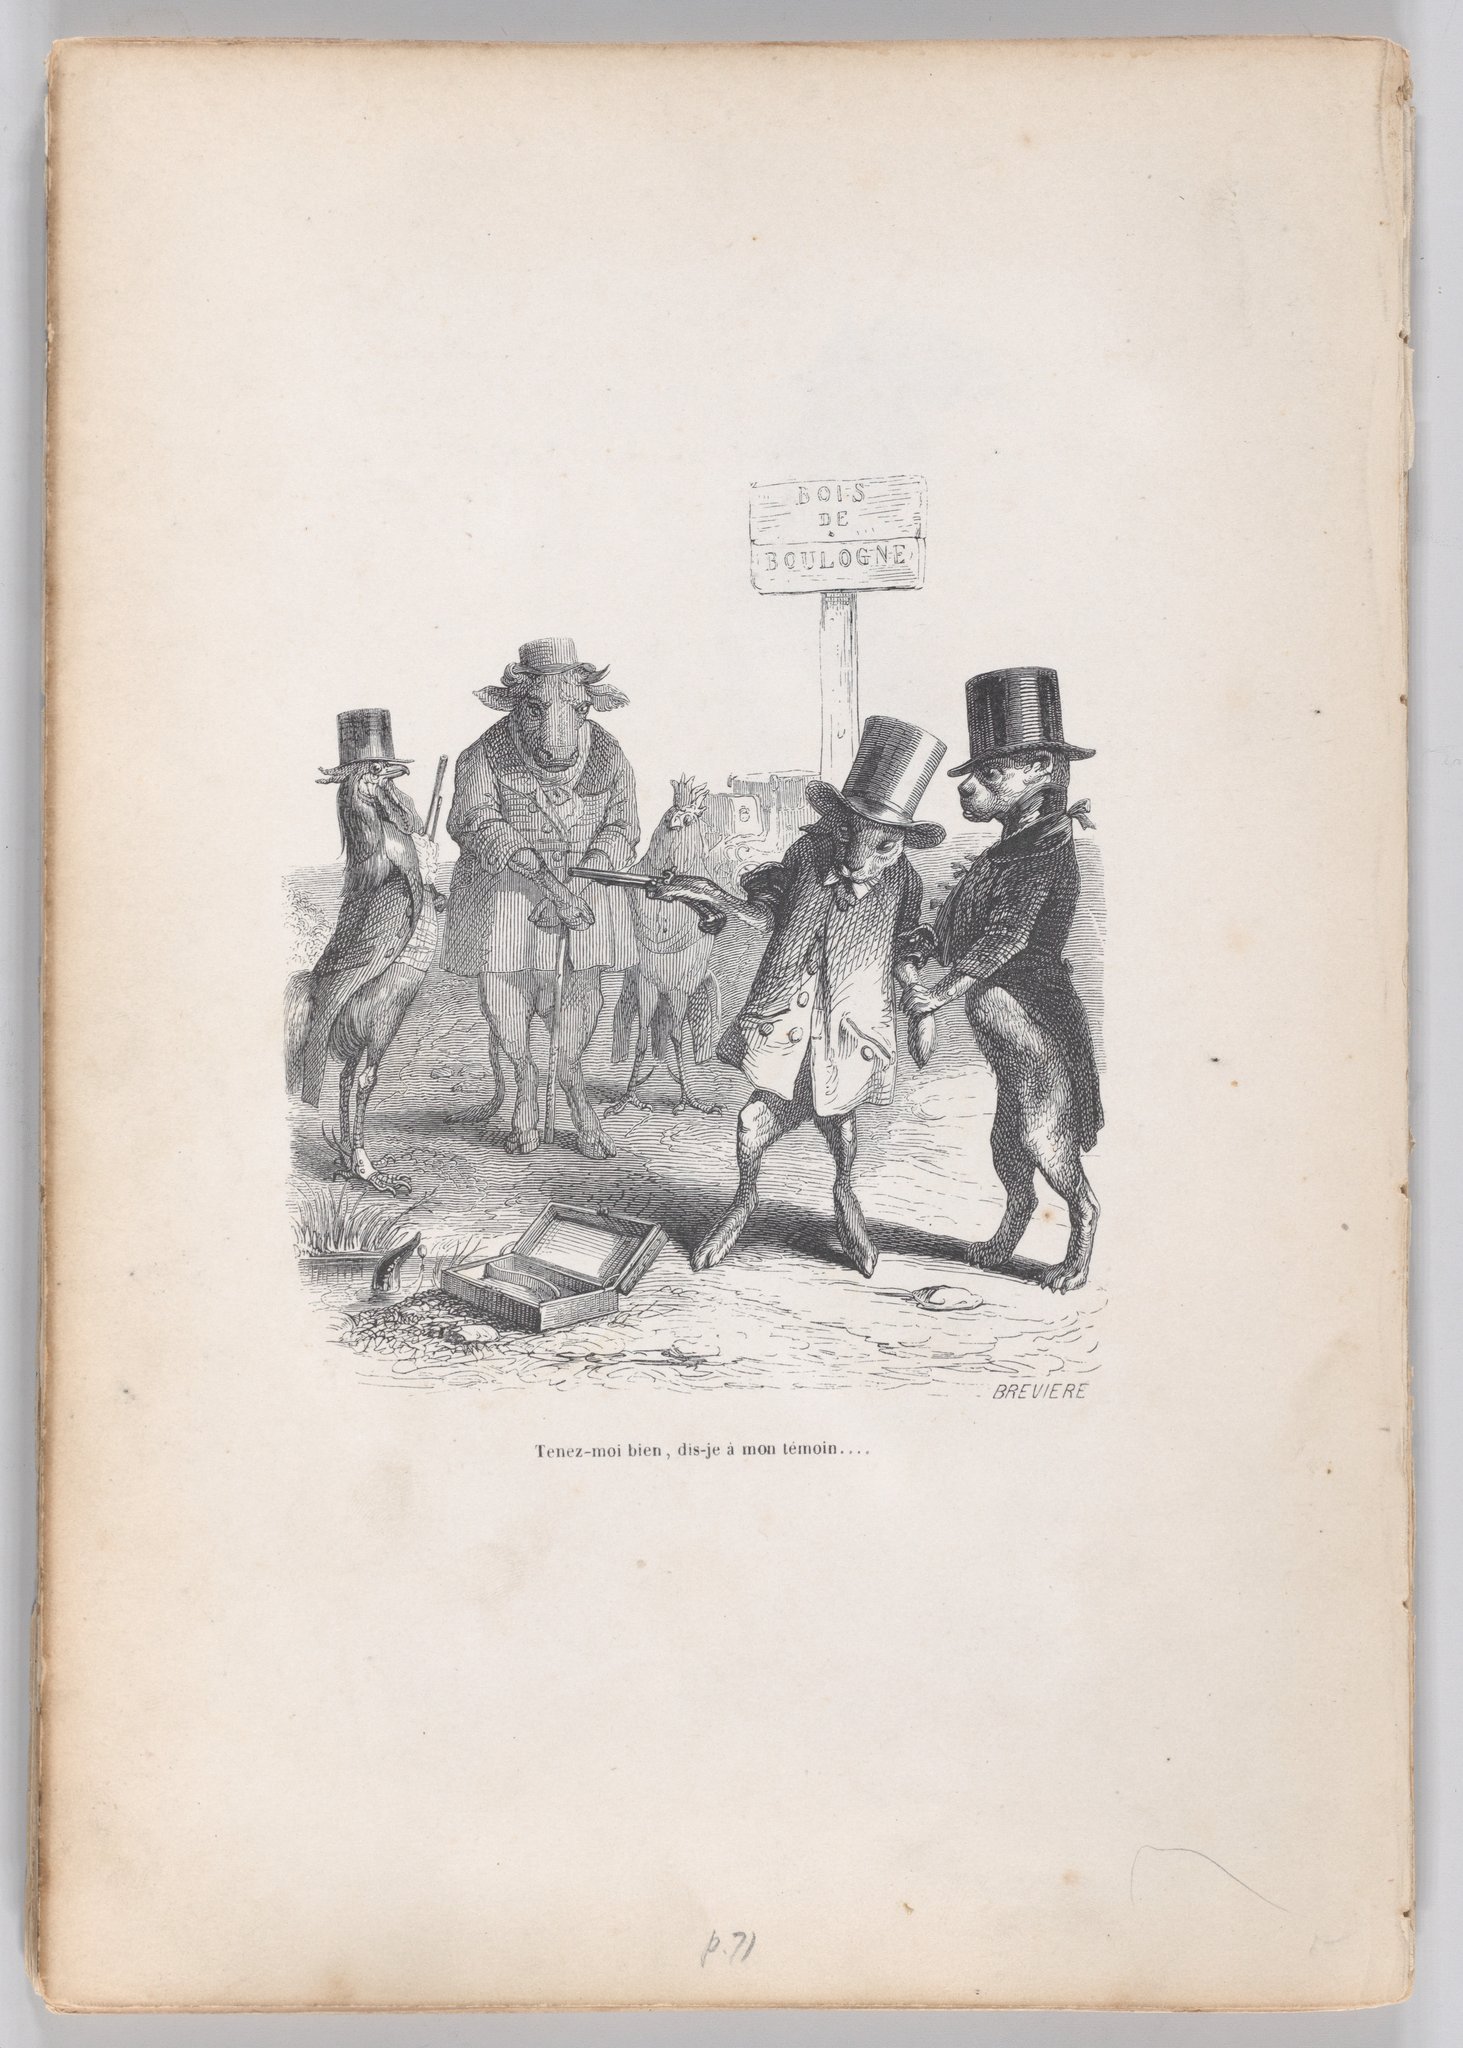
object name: print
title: Hold on to me, I am telling my witness..., from "Scenes from the Private and Public Life of Animals"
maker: j. j. grandville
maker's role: illustrator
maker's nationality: french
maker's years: 1803-1847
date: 1837-1847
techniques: engraving